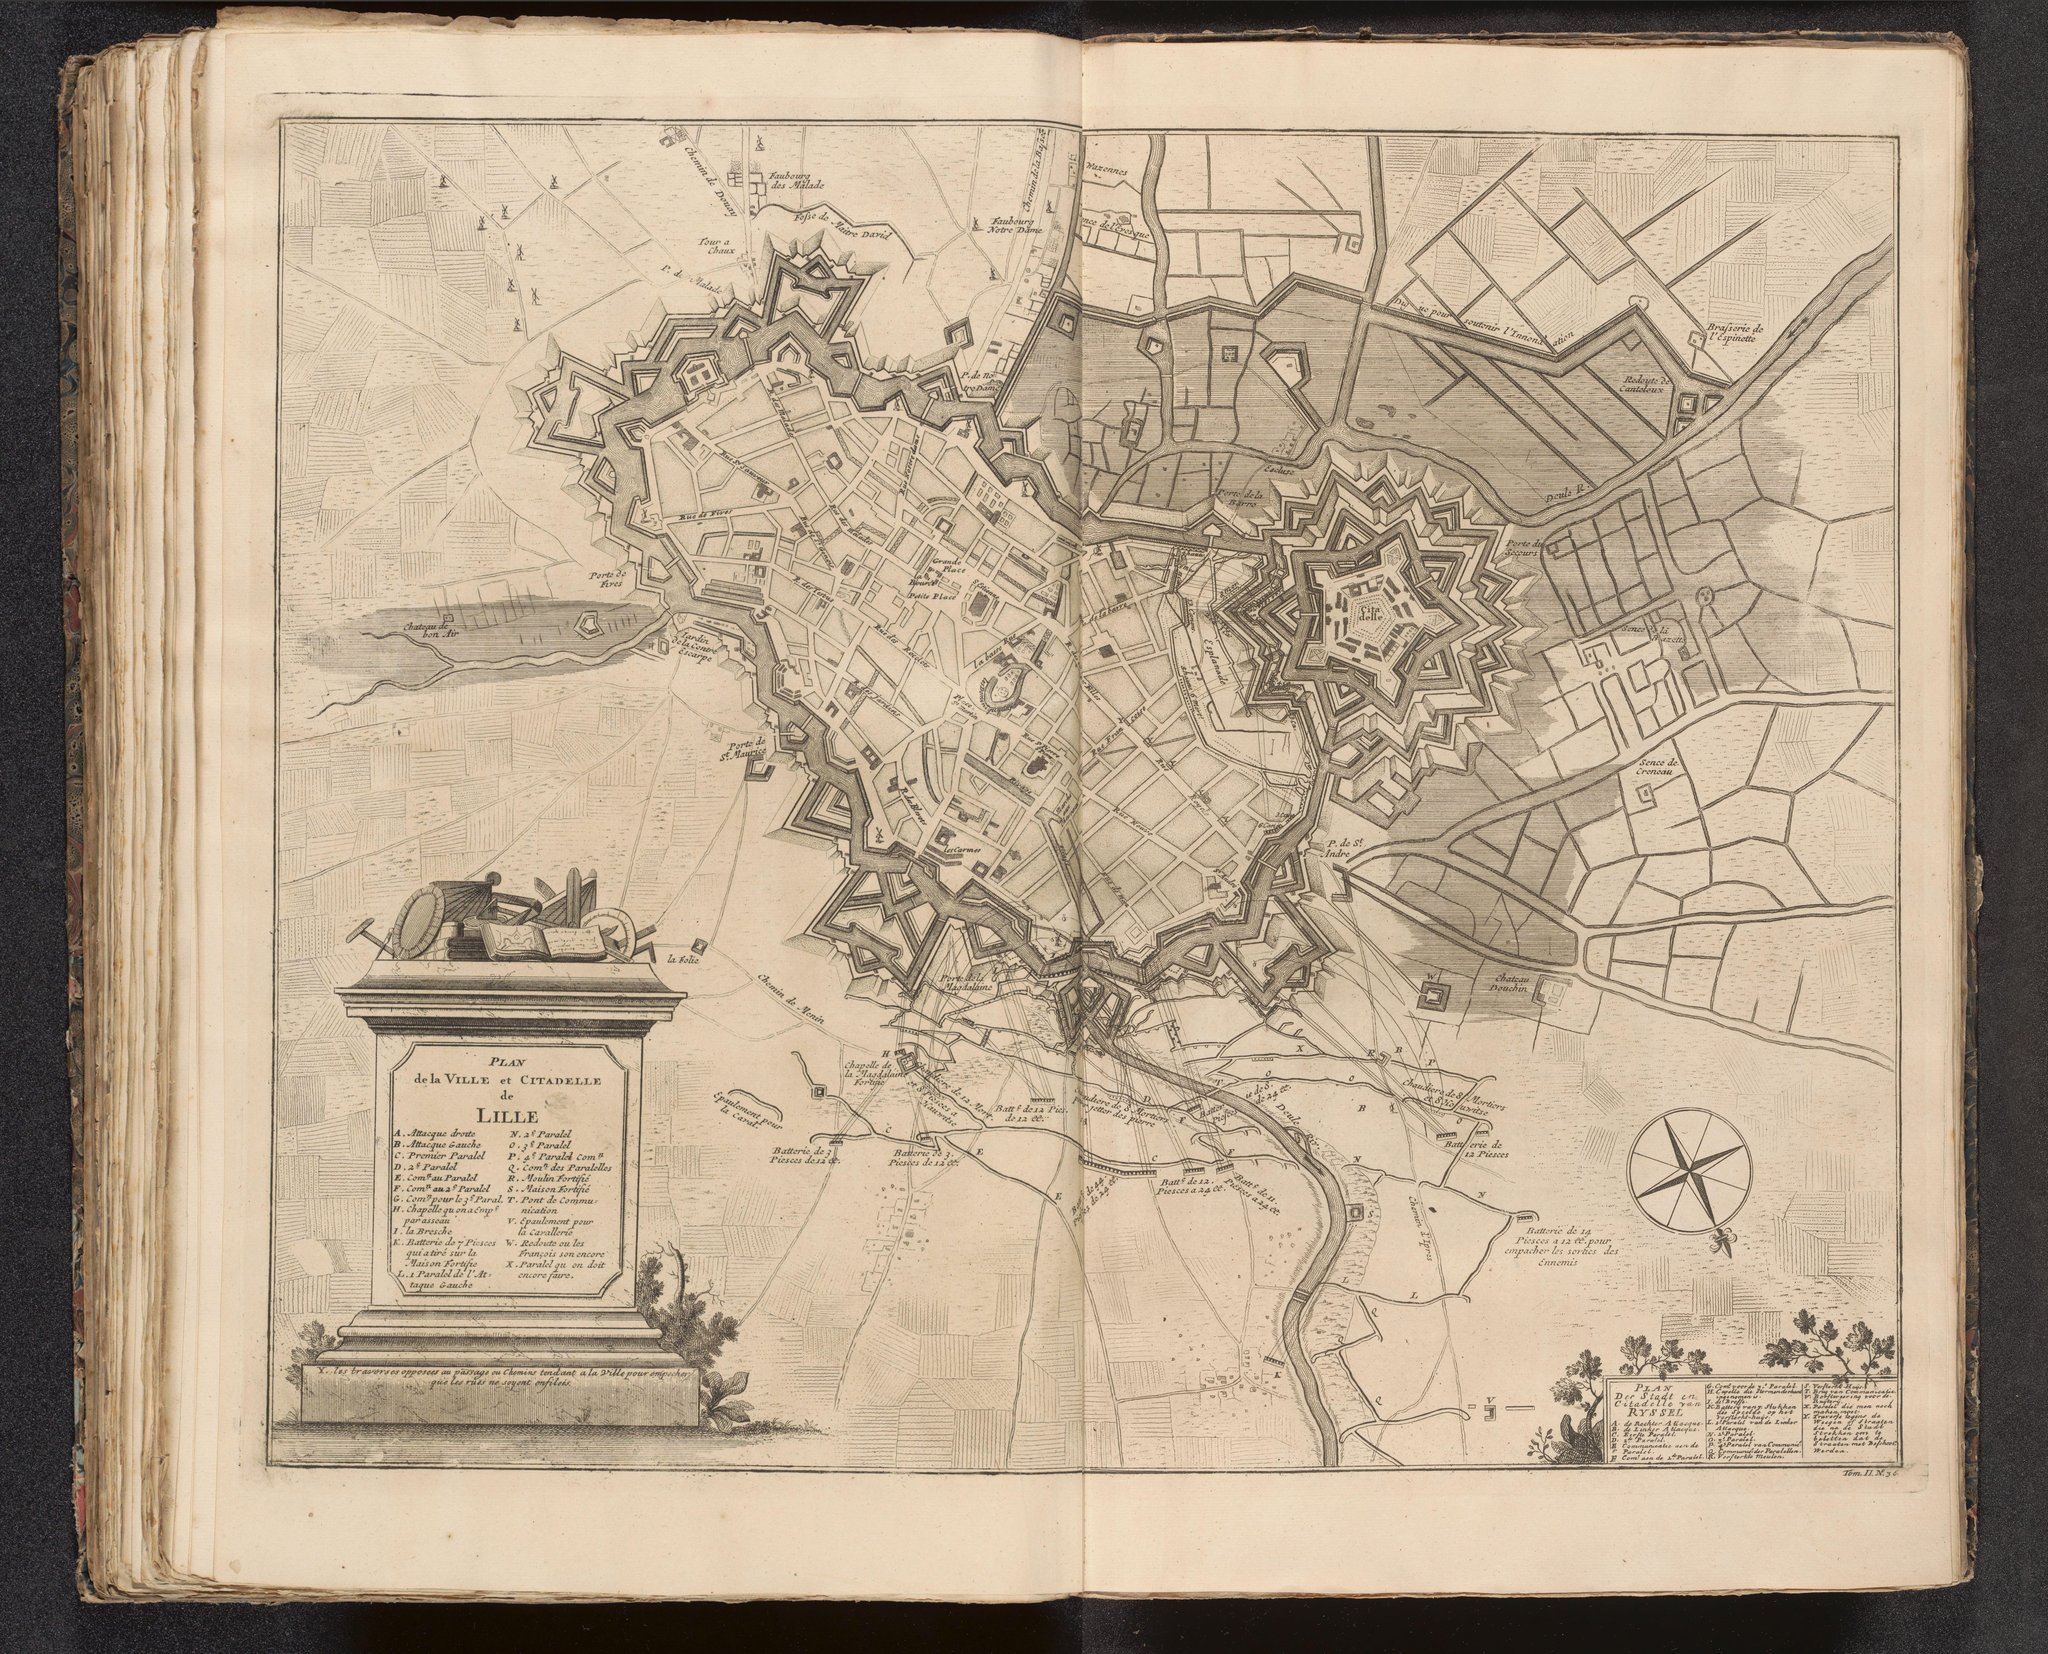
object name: print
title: Plattegrond van Lille, 1708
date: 1708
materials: paper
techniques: etching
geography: the hague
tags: johan willem friso (prins van oranje-nassau), john churchill (1e hertog van marlborough), siege, position war, maps of cities, lille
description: Plattegrond van Lille (Rijssel), belegerd door de Geallieerden vanaf 22 augustus en ingenomen op 23 oktober 1708. Genummerd rechtsonder: Tom. II. No. 36. Illustratie in het tweede deel van : [Jean] du Mont, Oorlogskundige beschryving van de veldslagen en belegeringen, der drie ... wydvermaarde krygsoversten... den Prins Eugenius van Savoye, den ... Hertog van Marlborough, en den Prins van Oranje en Nassau-Vriesland, in de editie van 1729. Dit tweede deel is hoofdzakelijk gewijd aan de daden van de hertog van Marlborough en prins Johan Willem Friso.